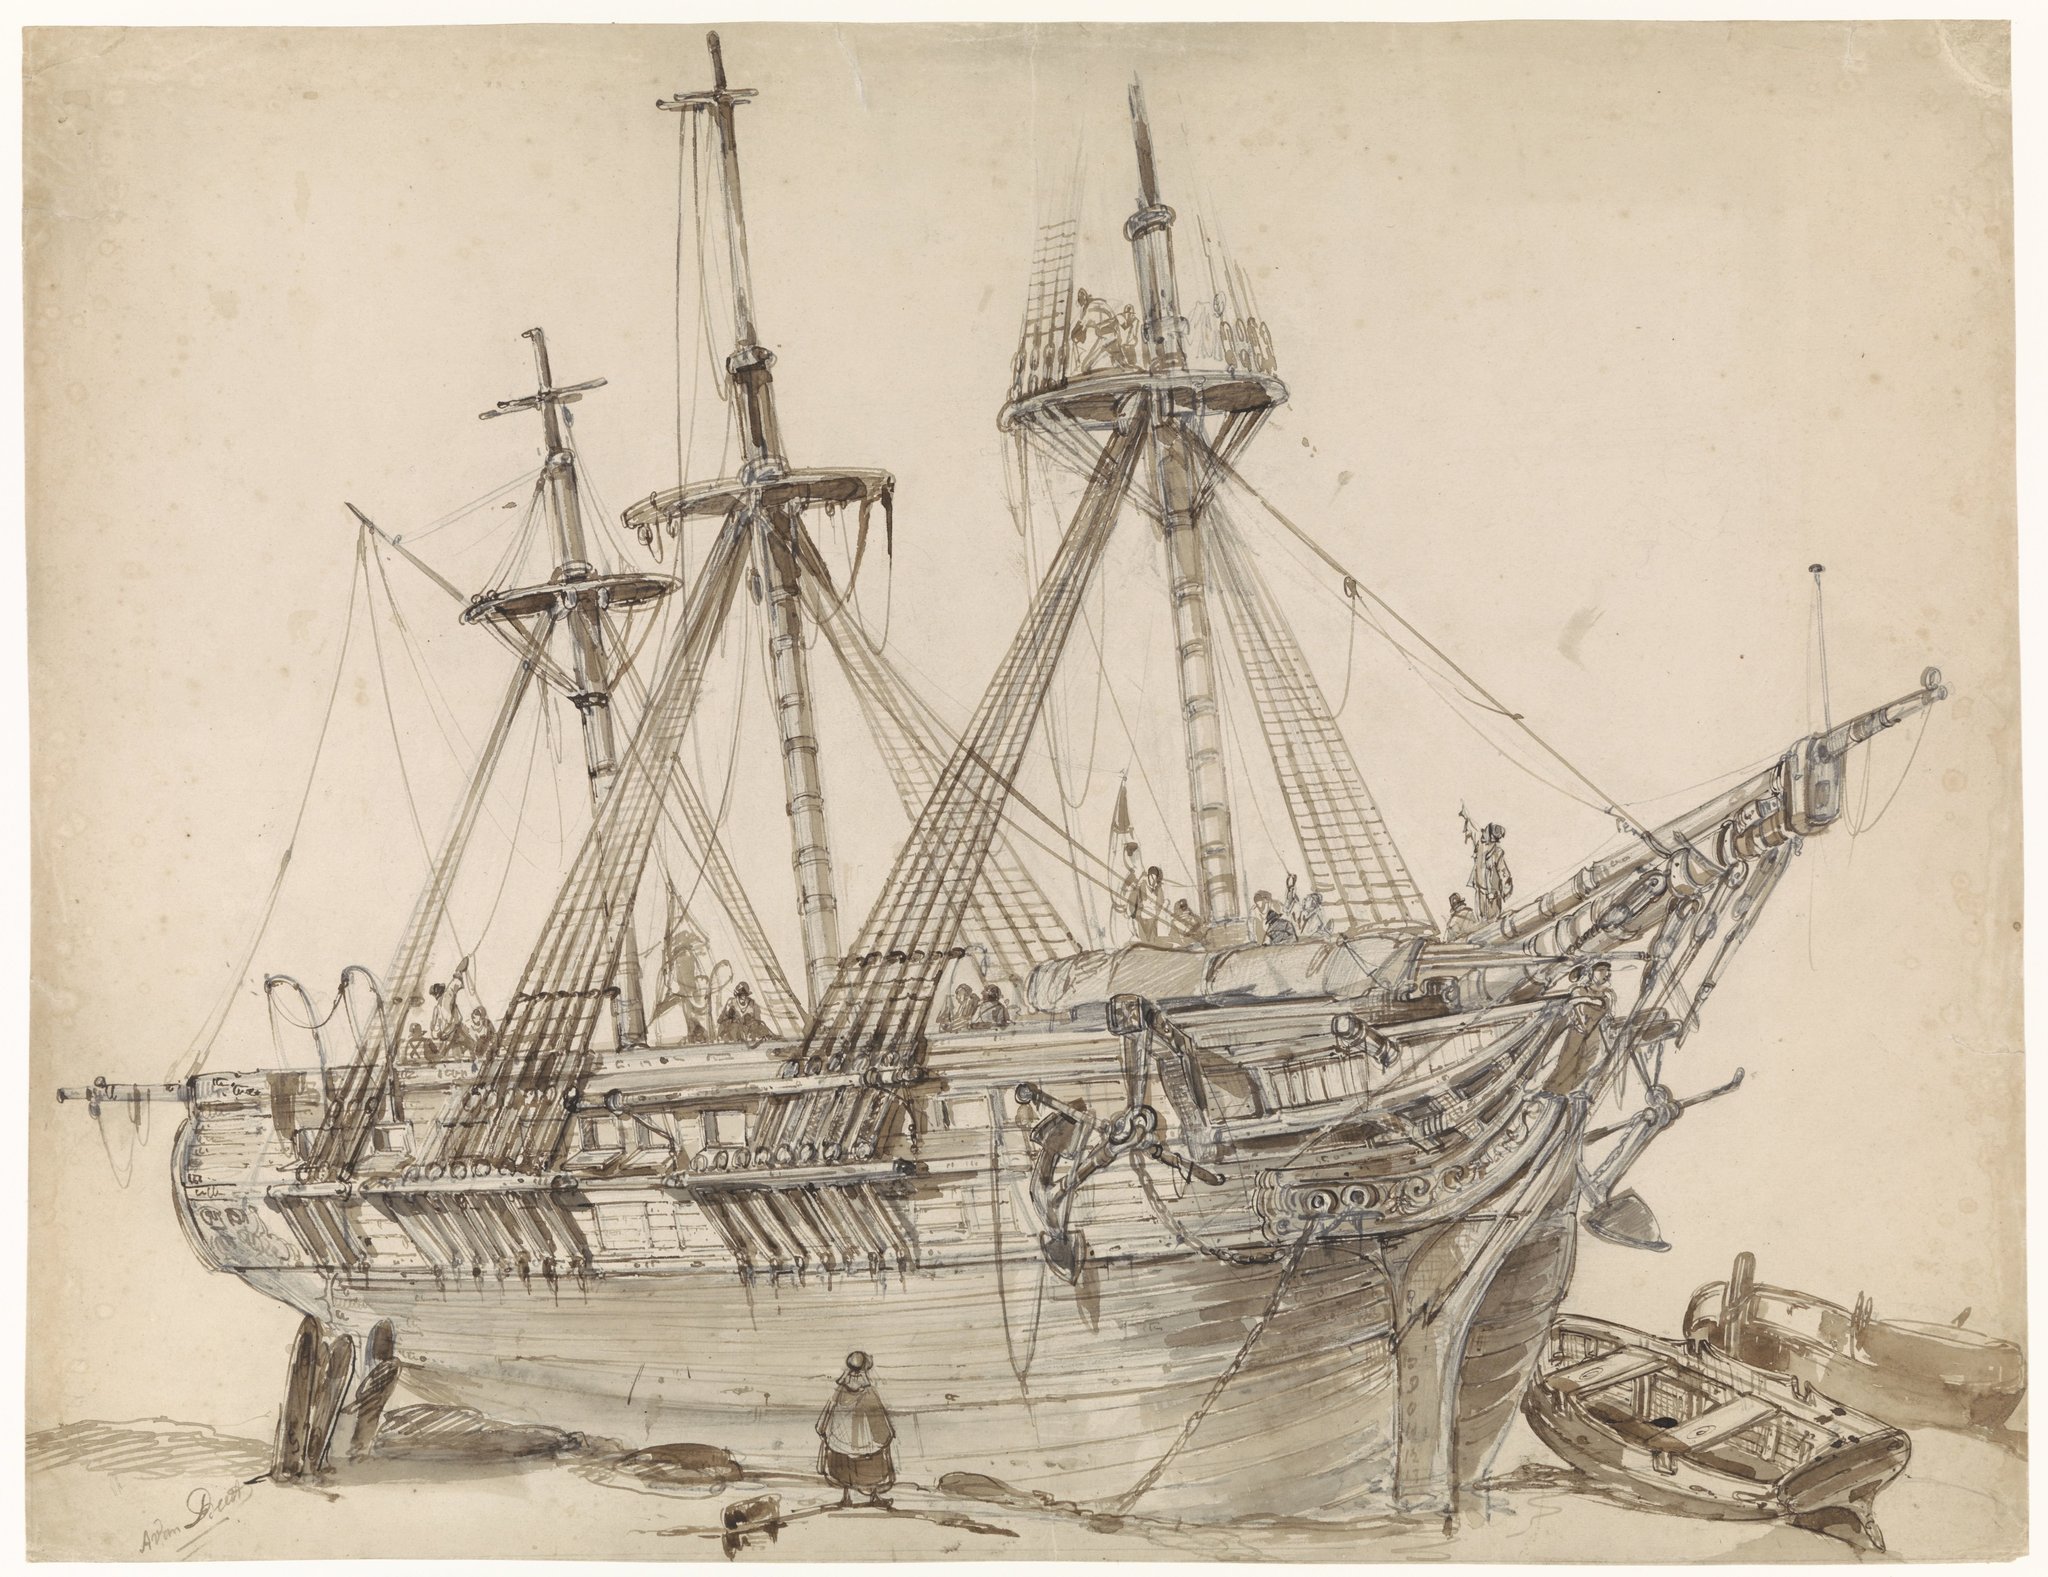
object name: drawing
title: Een driemaster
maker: albertus van beest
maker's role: draughtsman, print maker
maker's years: 1820-1860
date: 1830-1860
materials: ink, paper, pencil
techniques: brush, pen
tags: sailing-ship, sailing-boat